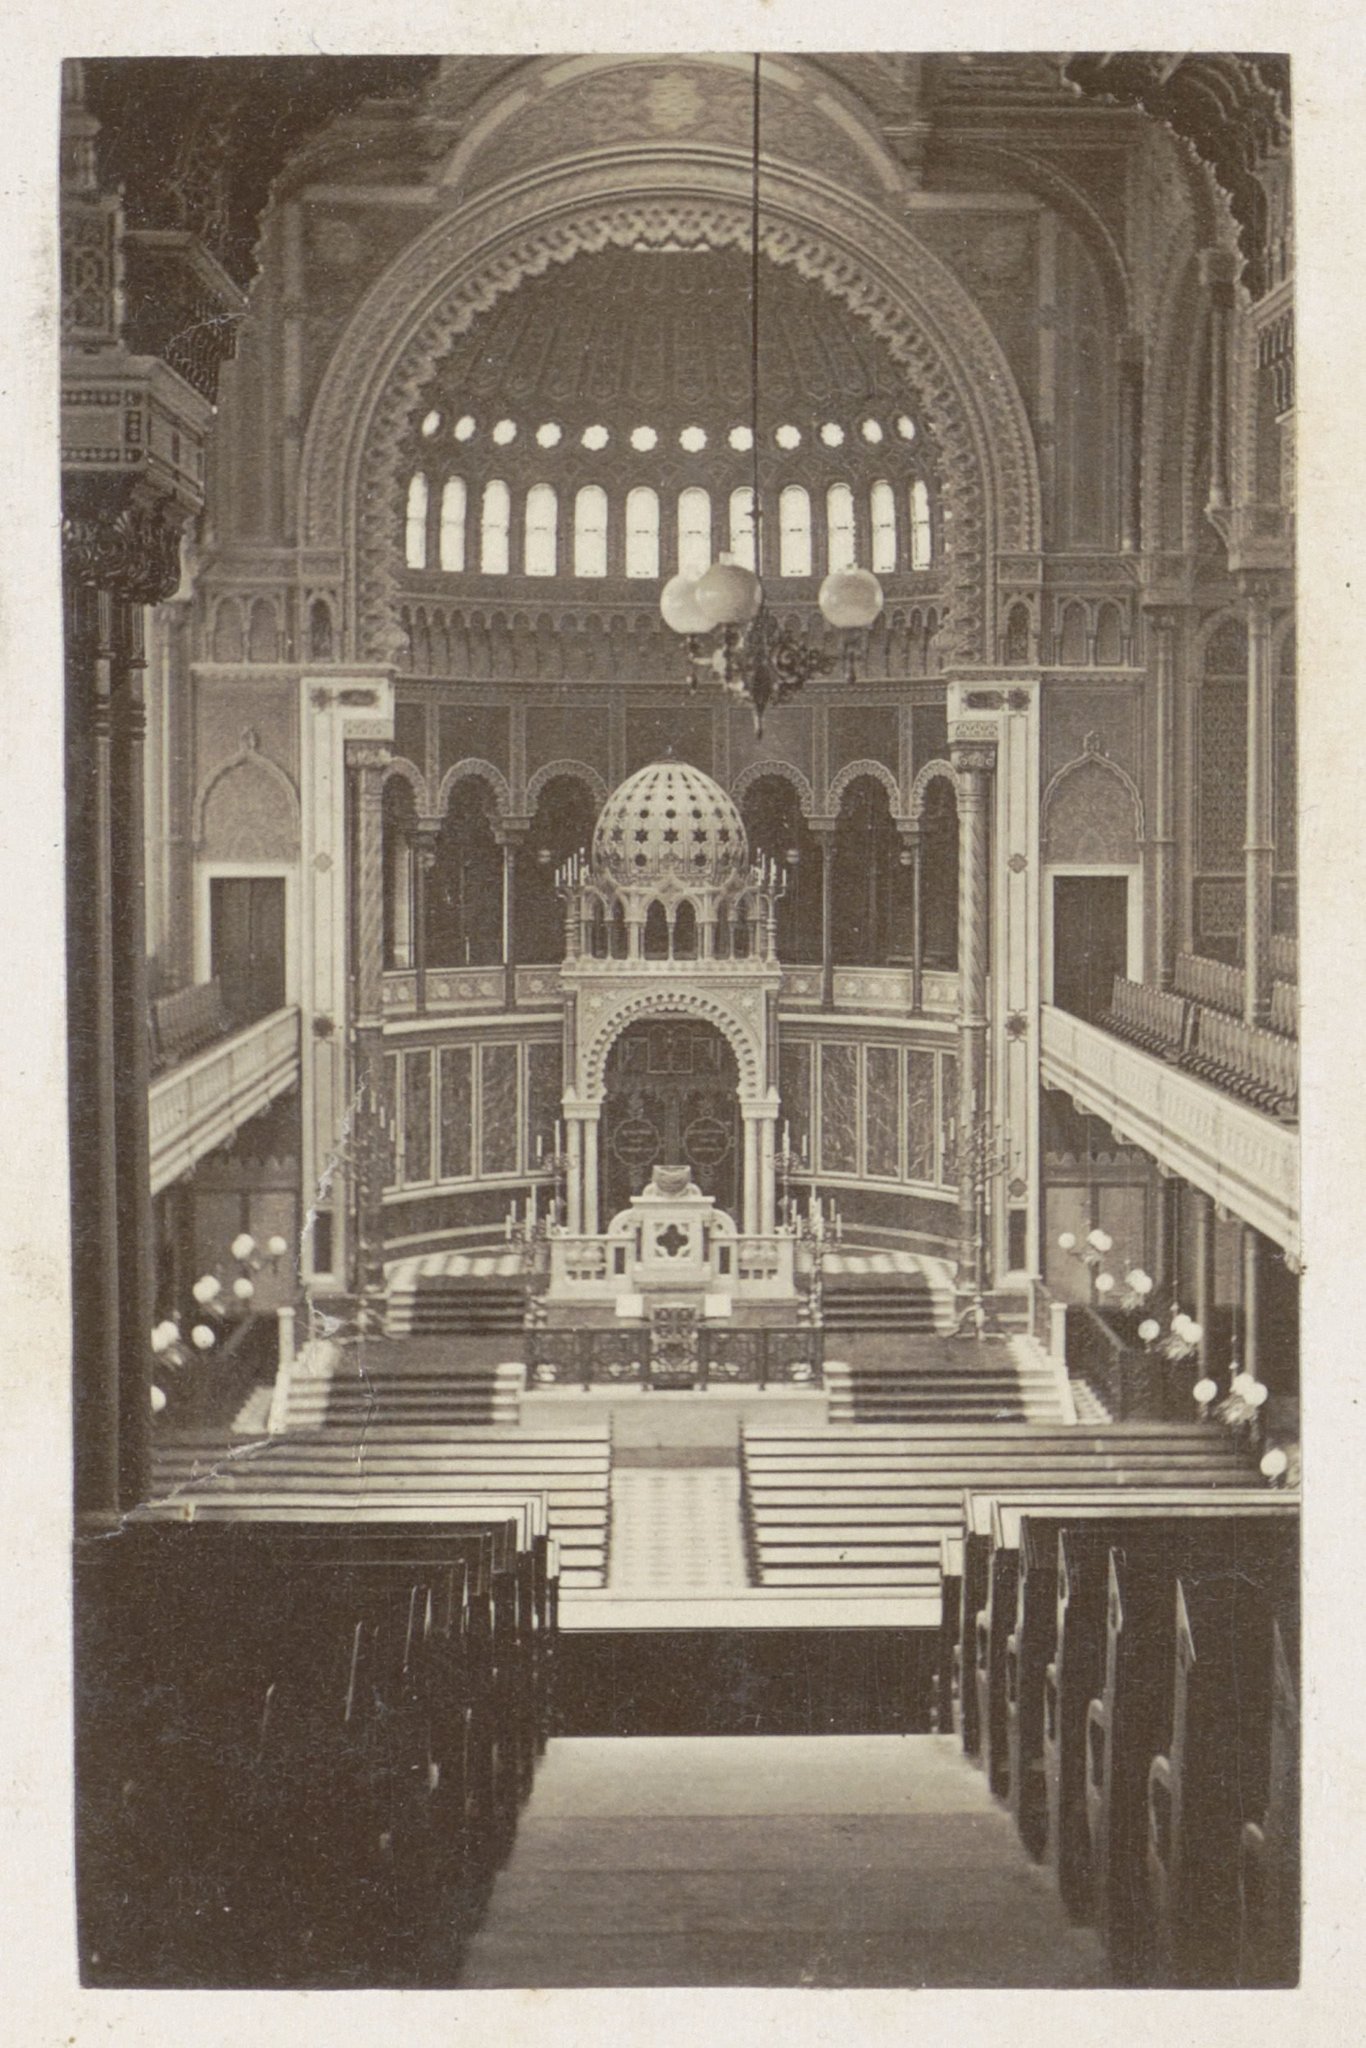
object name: photograph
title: Interieur van de Nieuwe Synagoge in Berlijn: banken en koor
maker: Anonymous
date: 1878-1890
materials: photographic support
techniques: albumen print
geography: berlin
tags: choir in synagogue ~ jewish religion, benches, seats ~ synagogue, berlin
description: Onderdeel van Reisalbum Europese steden, vermoedelijk Zweeds.